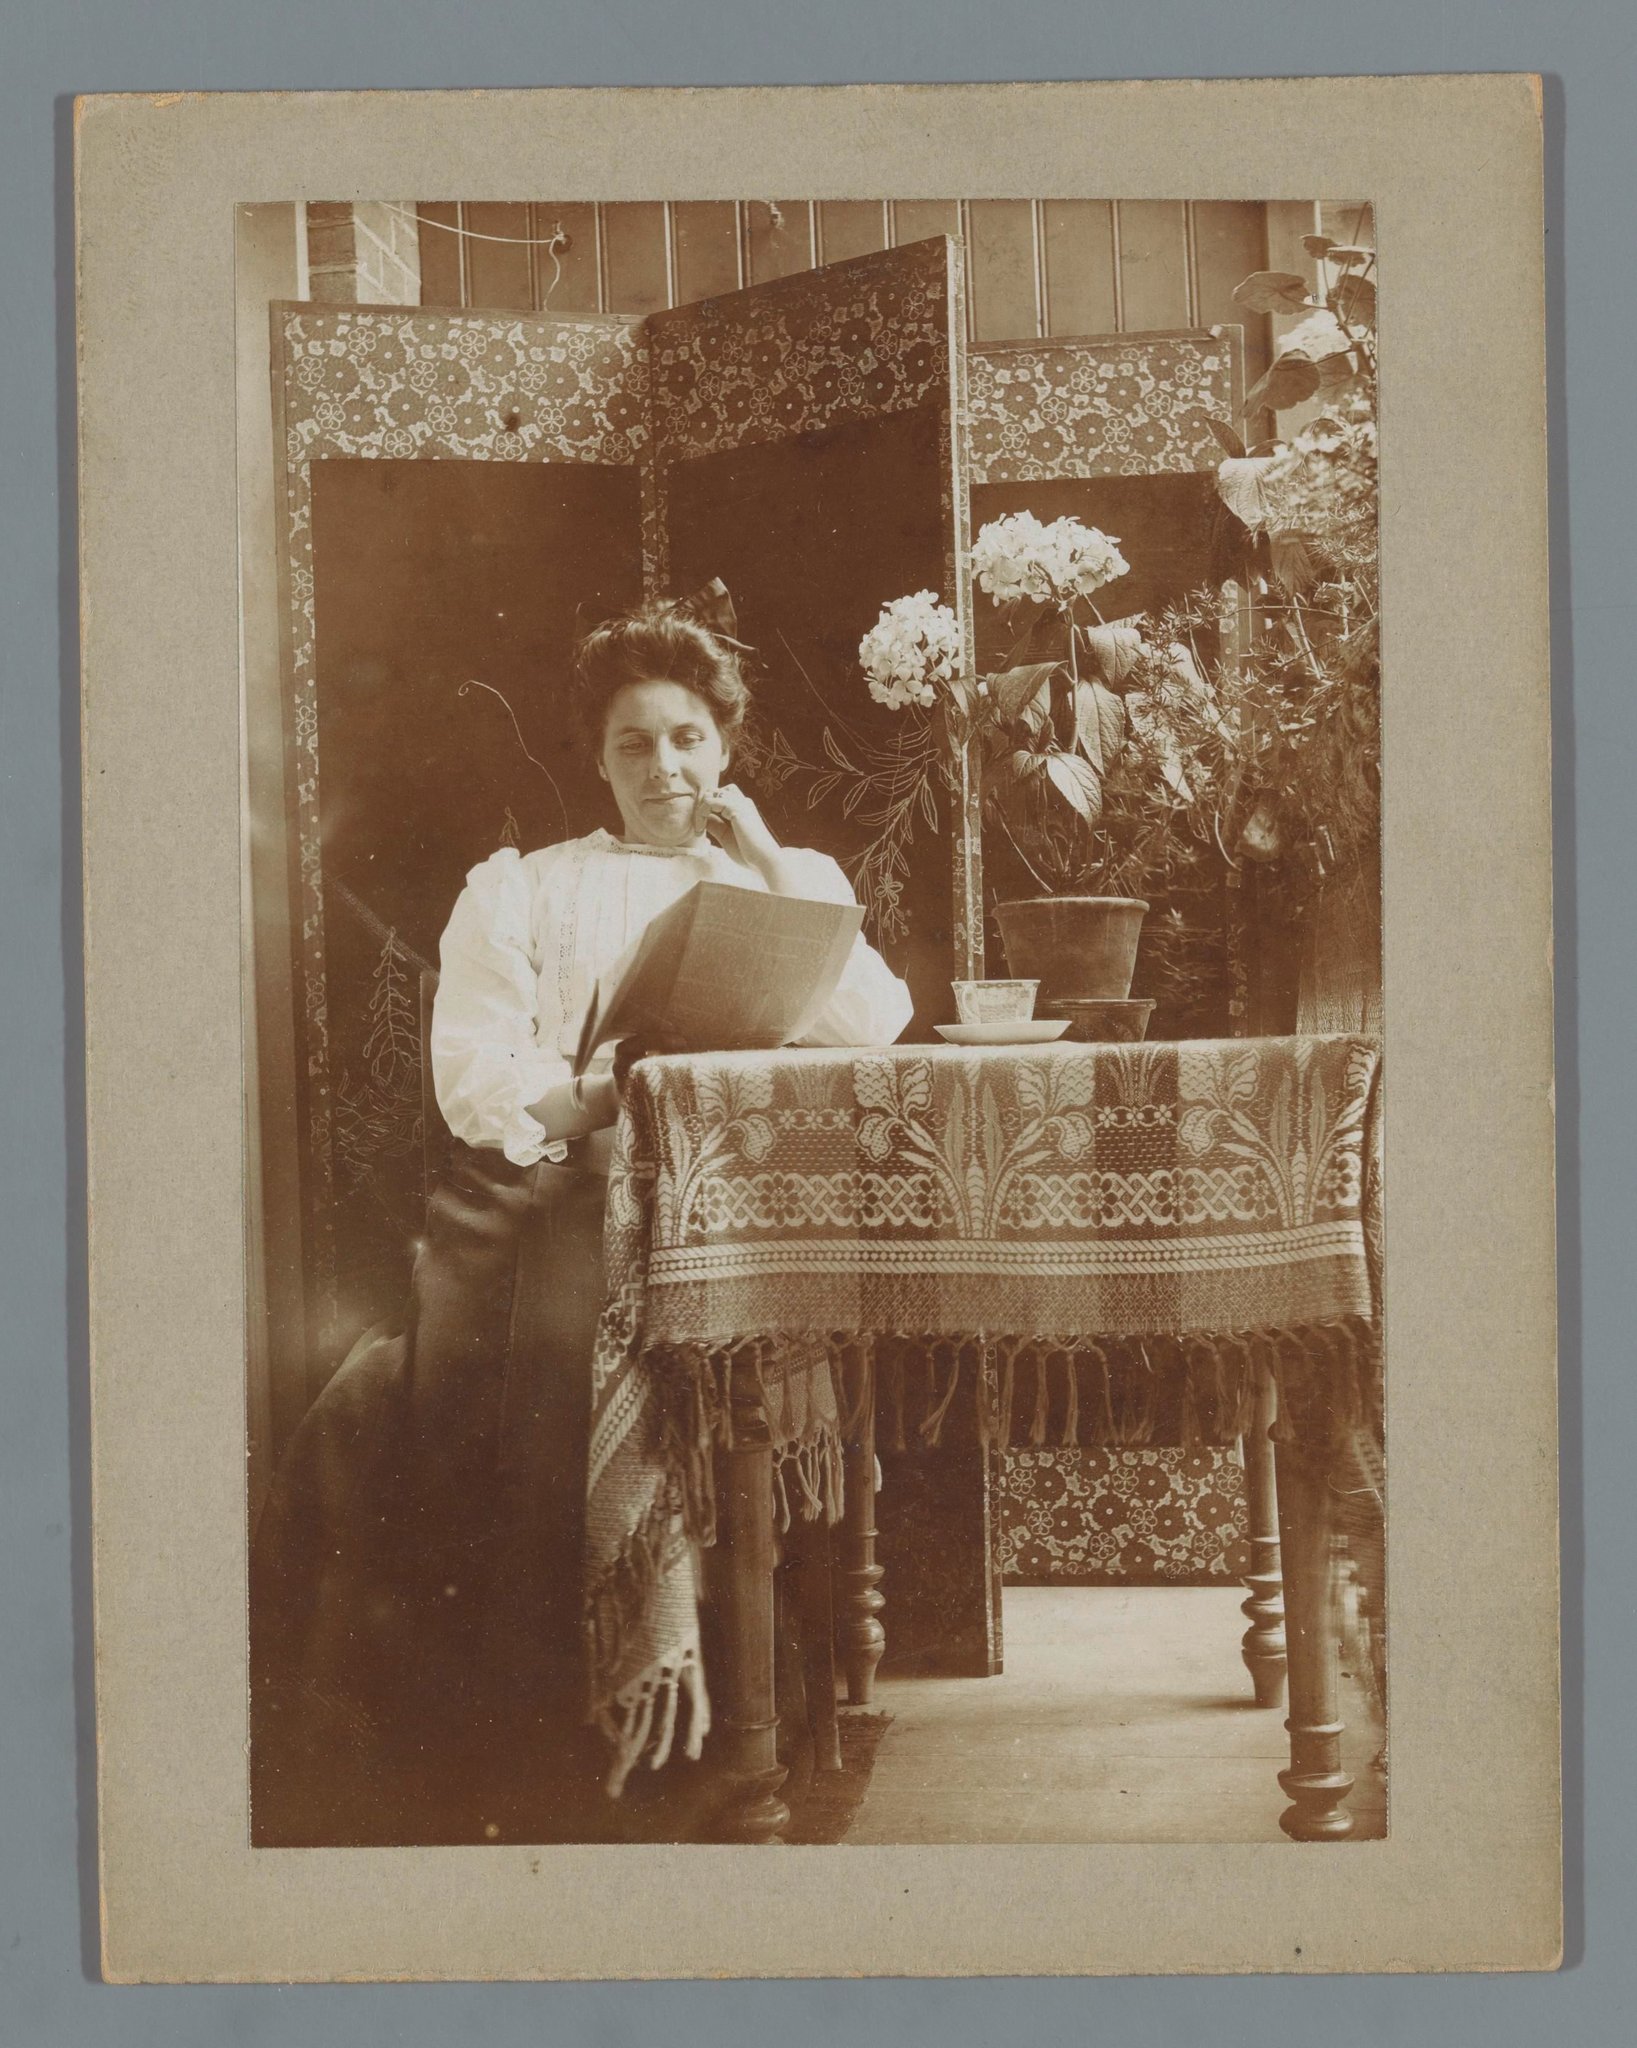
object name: photograph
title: Portret van onbekende lezende vrouw voor een kamerscherm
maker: Anonymous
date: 1900-1915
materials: cardboard, photographic support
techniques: collodion silver print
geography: netherlands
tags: adult woman, reading, screen, folding screen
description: RP-F-F20714 is op dezelfde locatie gemaakt.